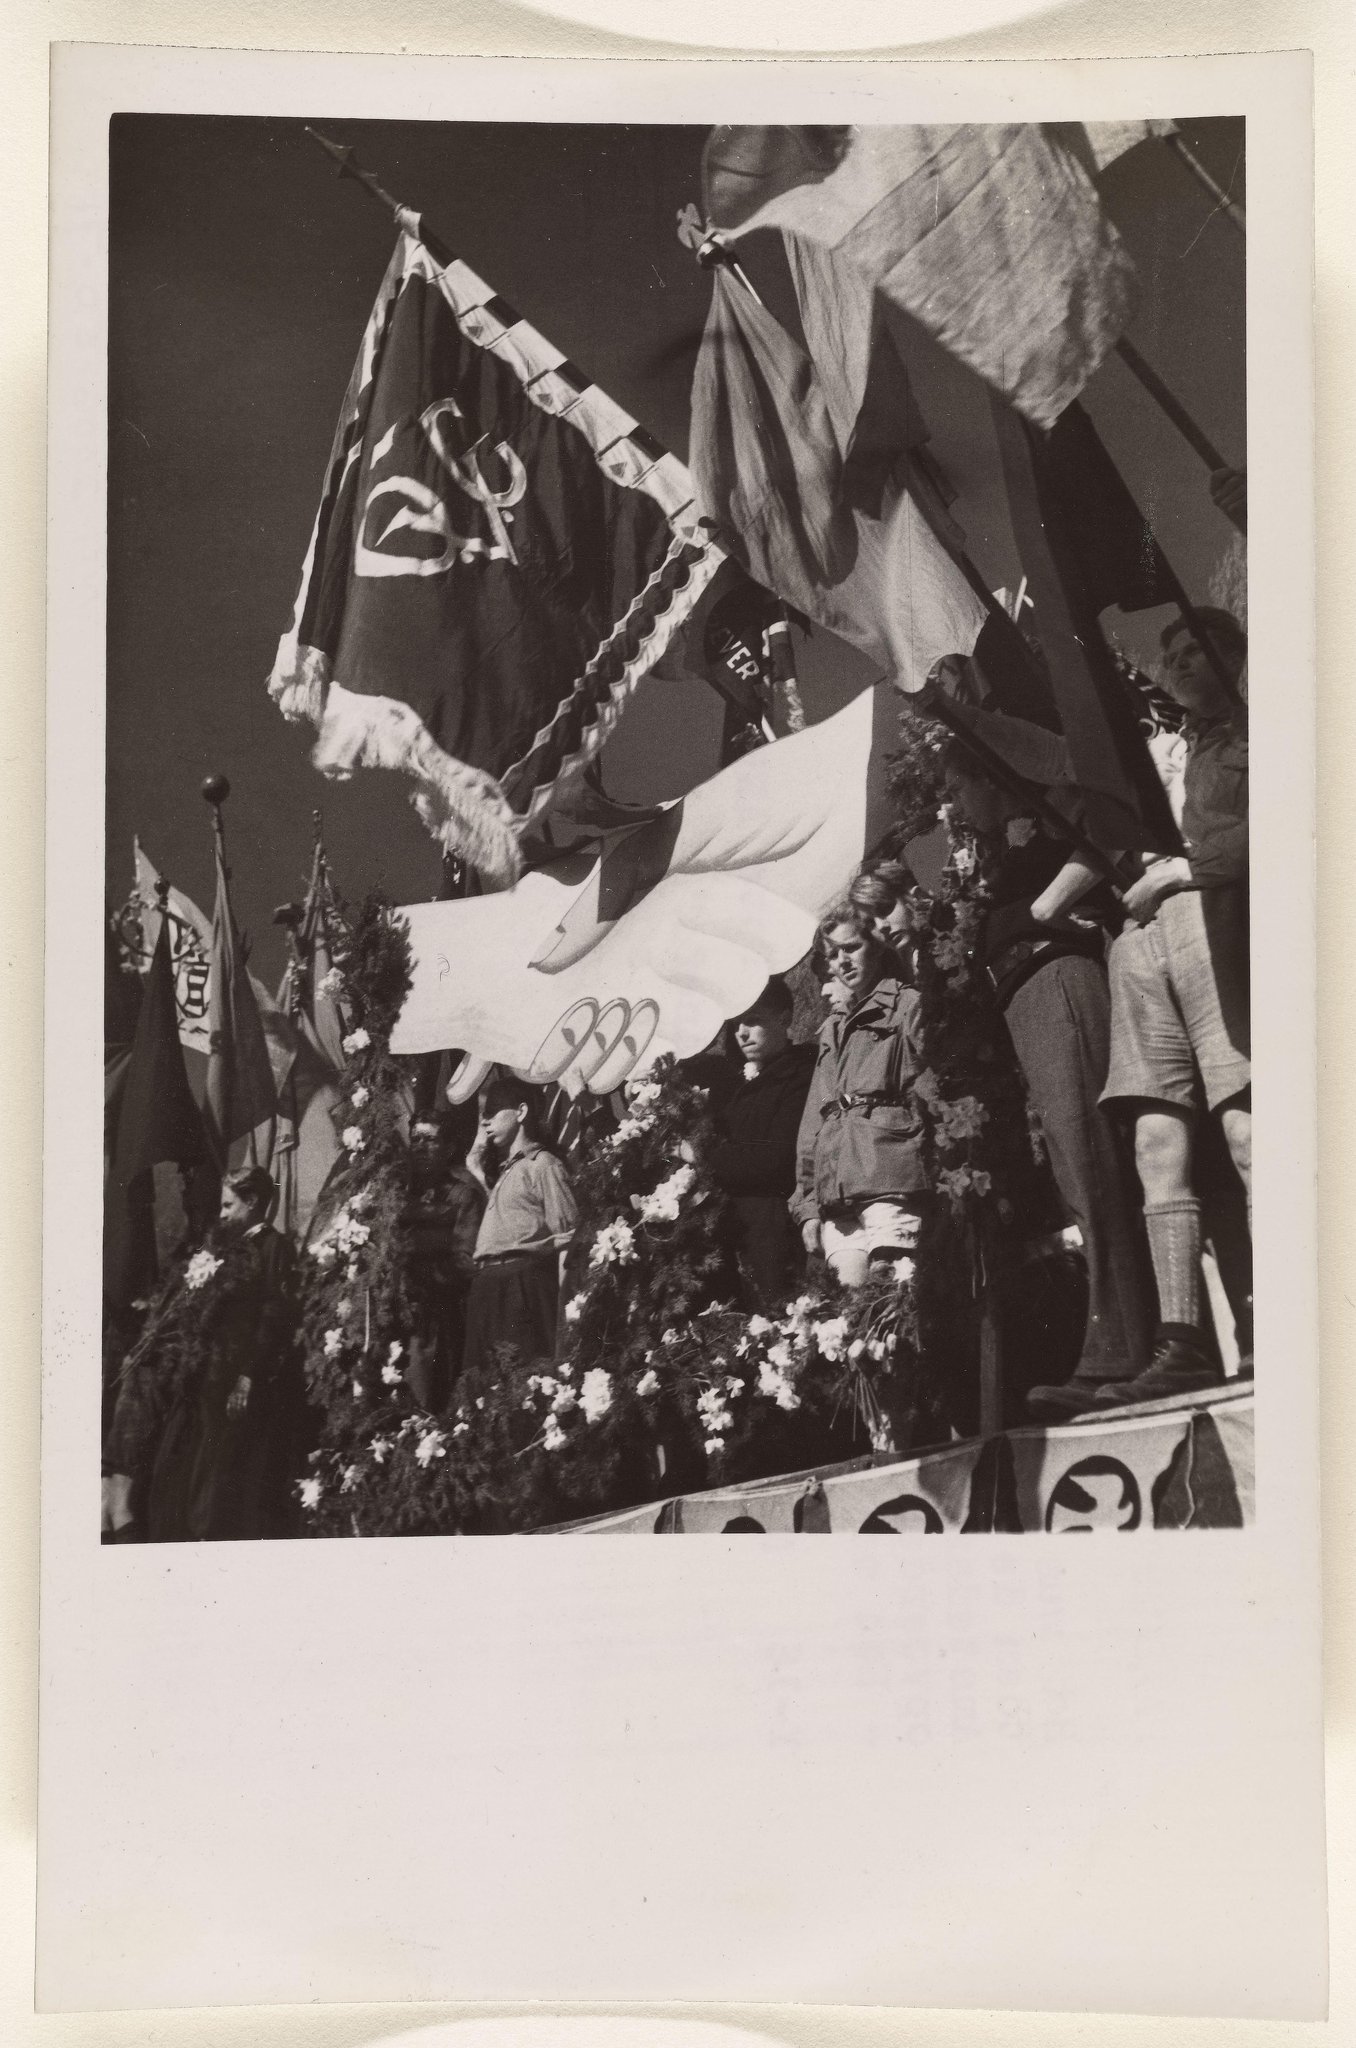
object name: photograph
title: Paasfeest AJC: Arbeiders Jeugd Centrale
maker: charles breijer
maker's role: fotograaf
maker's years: 1914-2011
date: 1945-1950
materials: photographic support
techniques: photography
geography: amsterdam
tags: amsterdam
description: Opvoering van een symbolisch spel genaamd "Bevrijde vogels" door de AJC en JVO. 10.000 Leden deden er aan mee. De jongeren staan op een podium met vlaggen, bloemen en twee handen.